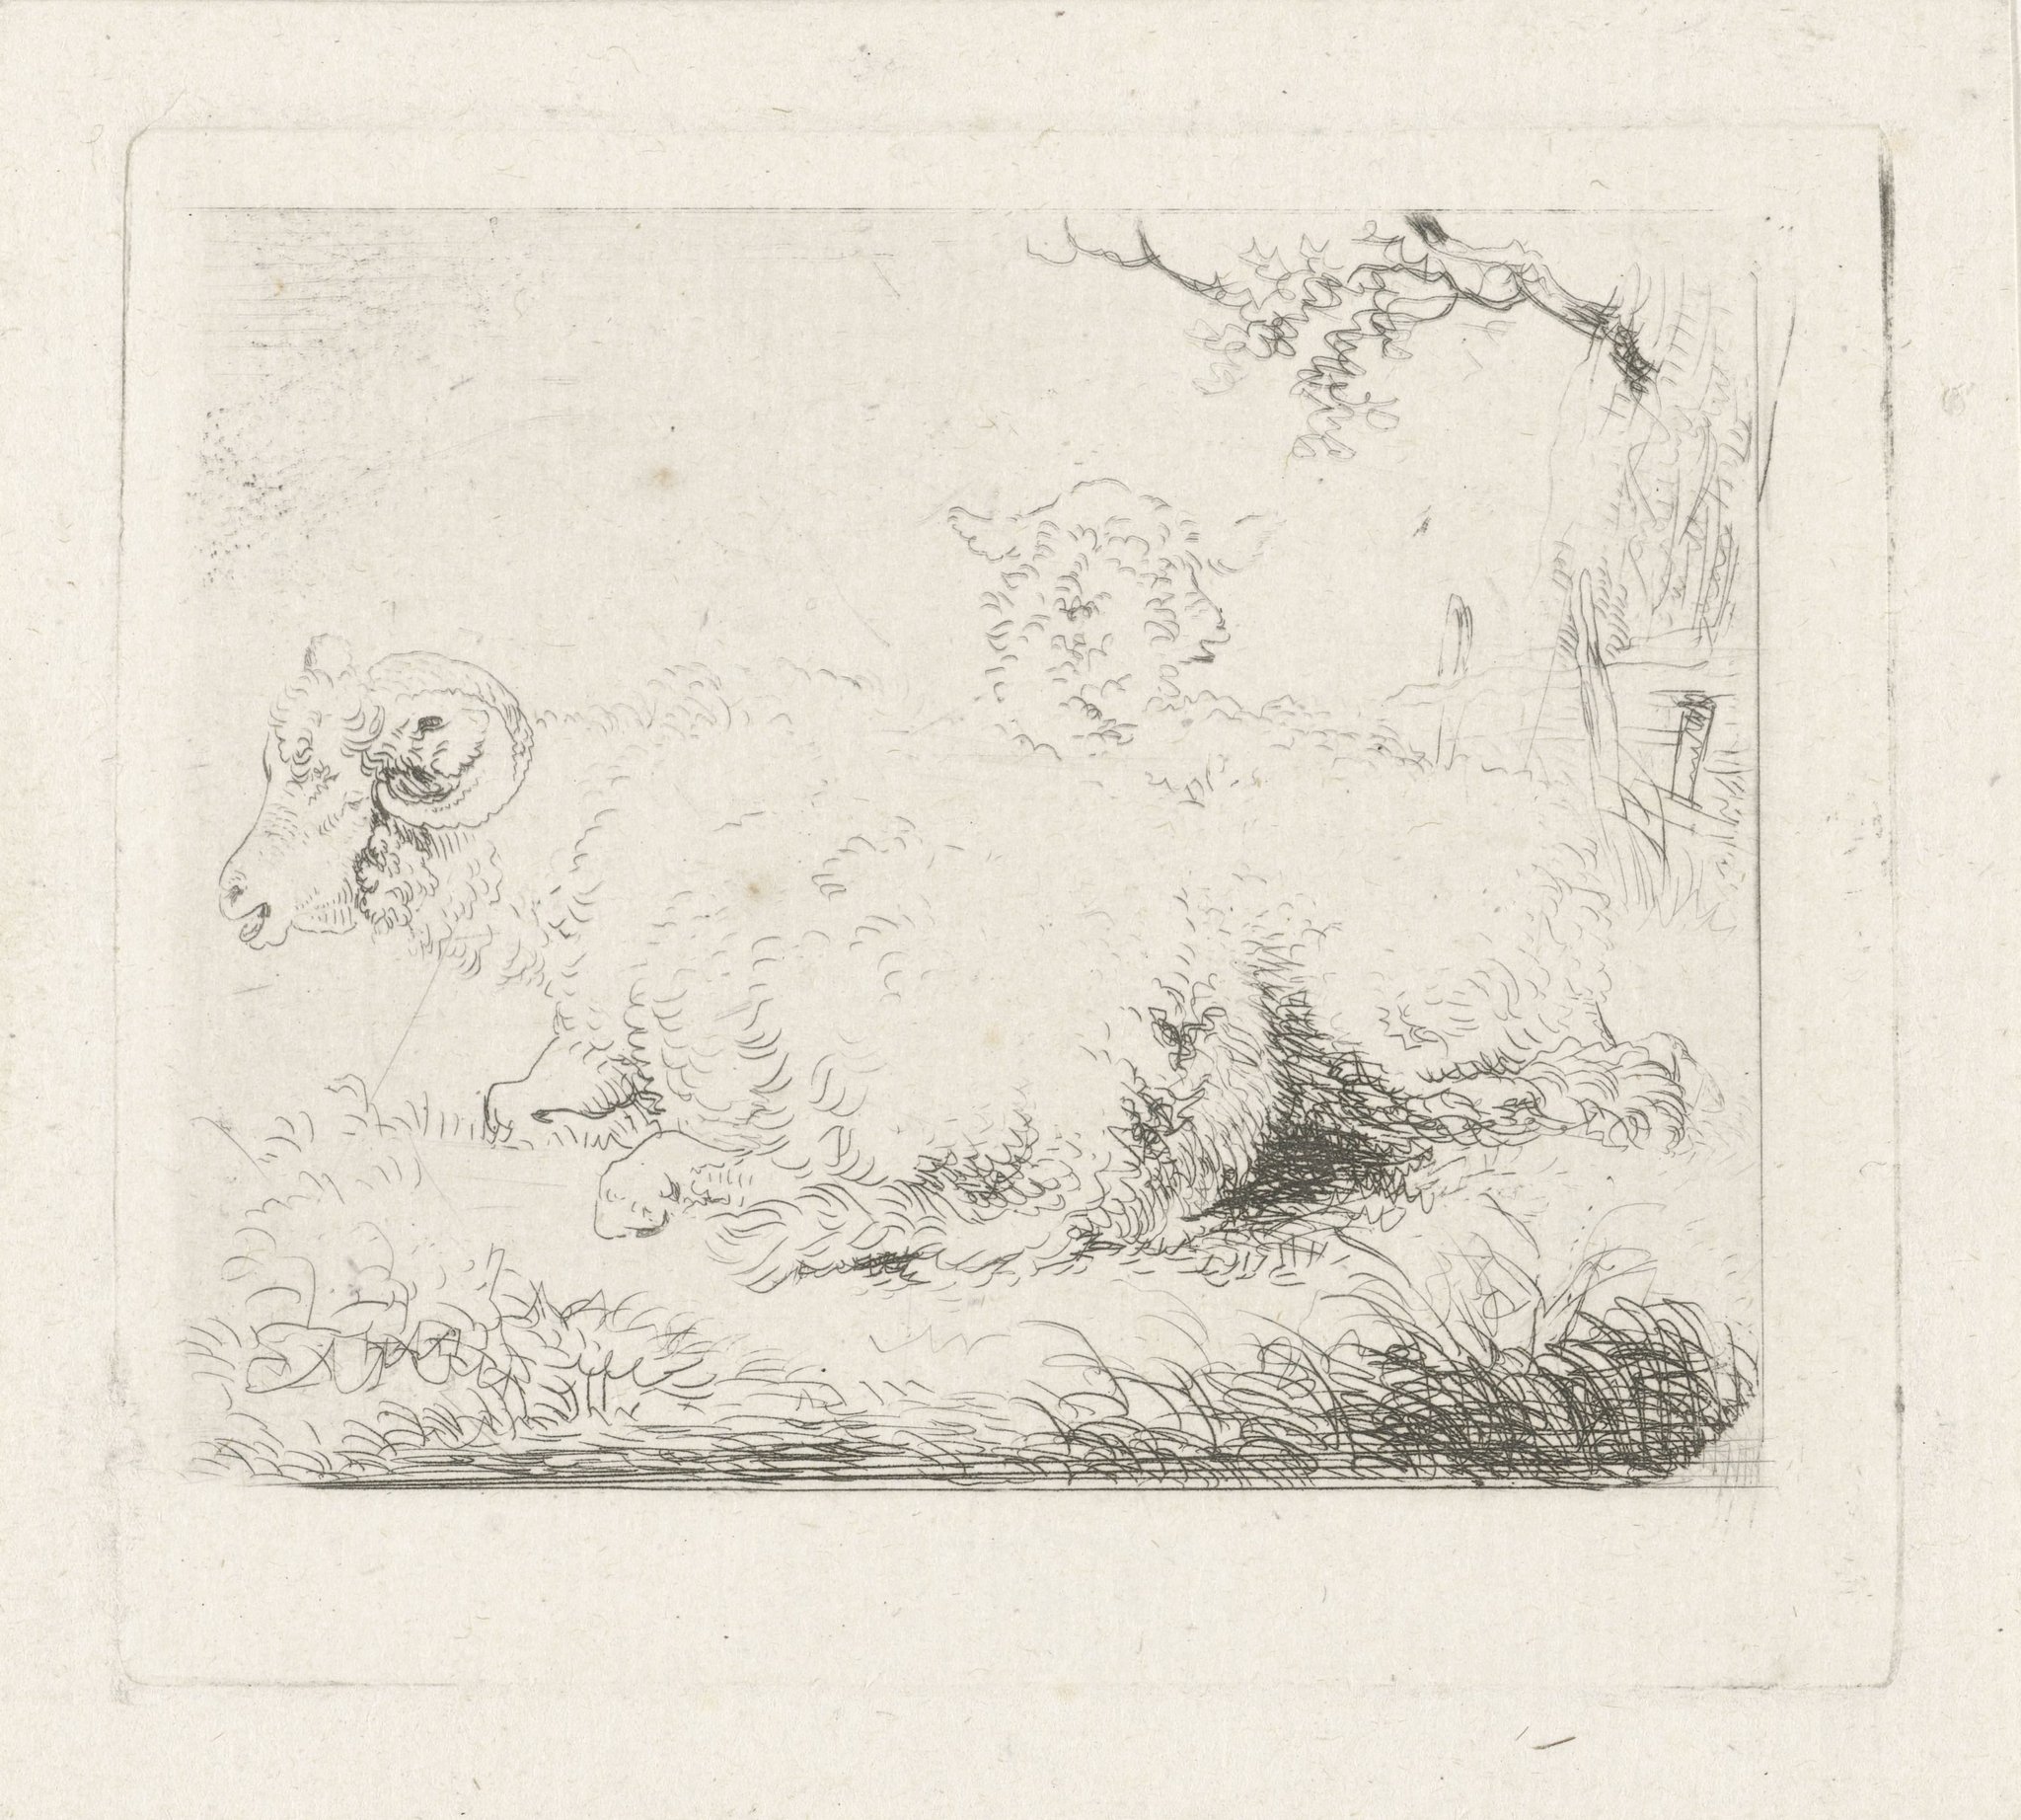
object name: print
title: Liggend schaap en ram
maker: pieter gerardus van os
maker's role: draughtsman, painter, print maker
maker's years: 1776-1839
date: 1791-1839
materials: paper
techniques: etching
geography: netherlands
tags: sheep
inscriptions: collector's mark: Lugt 2228